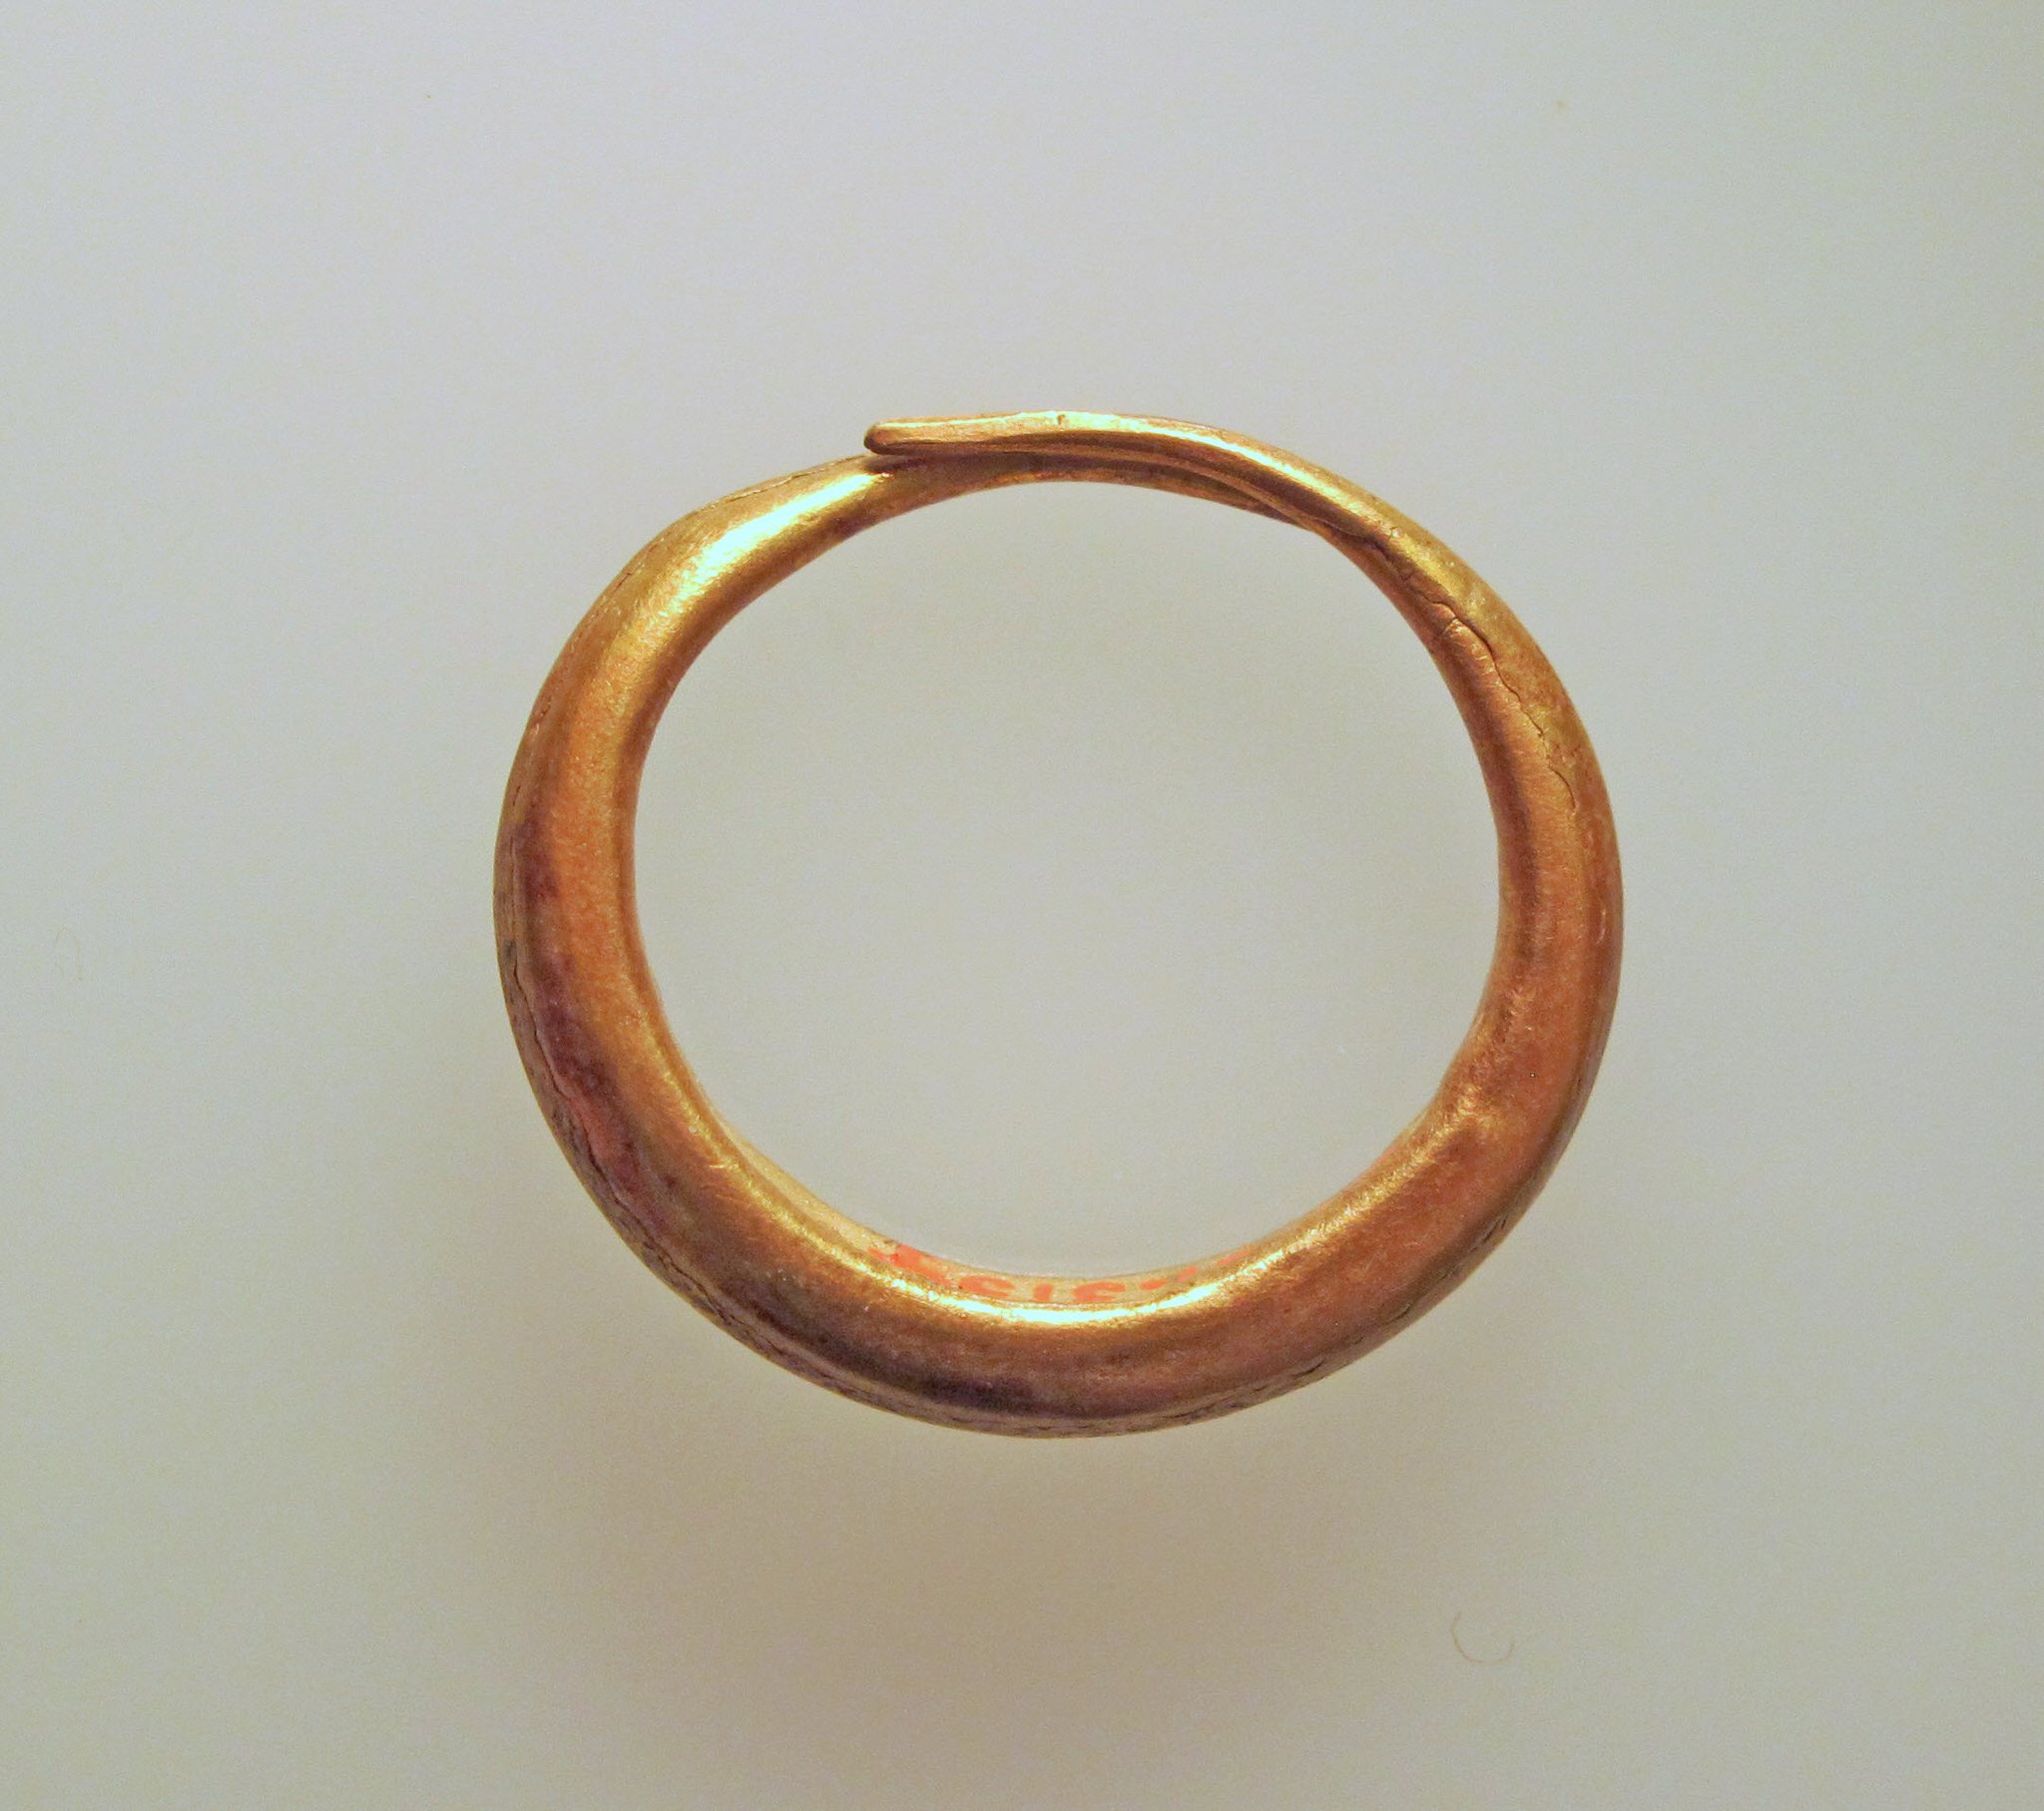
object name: earring of simple form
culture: cypriot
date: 3900 BCE-100 CE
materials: gold